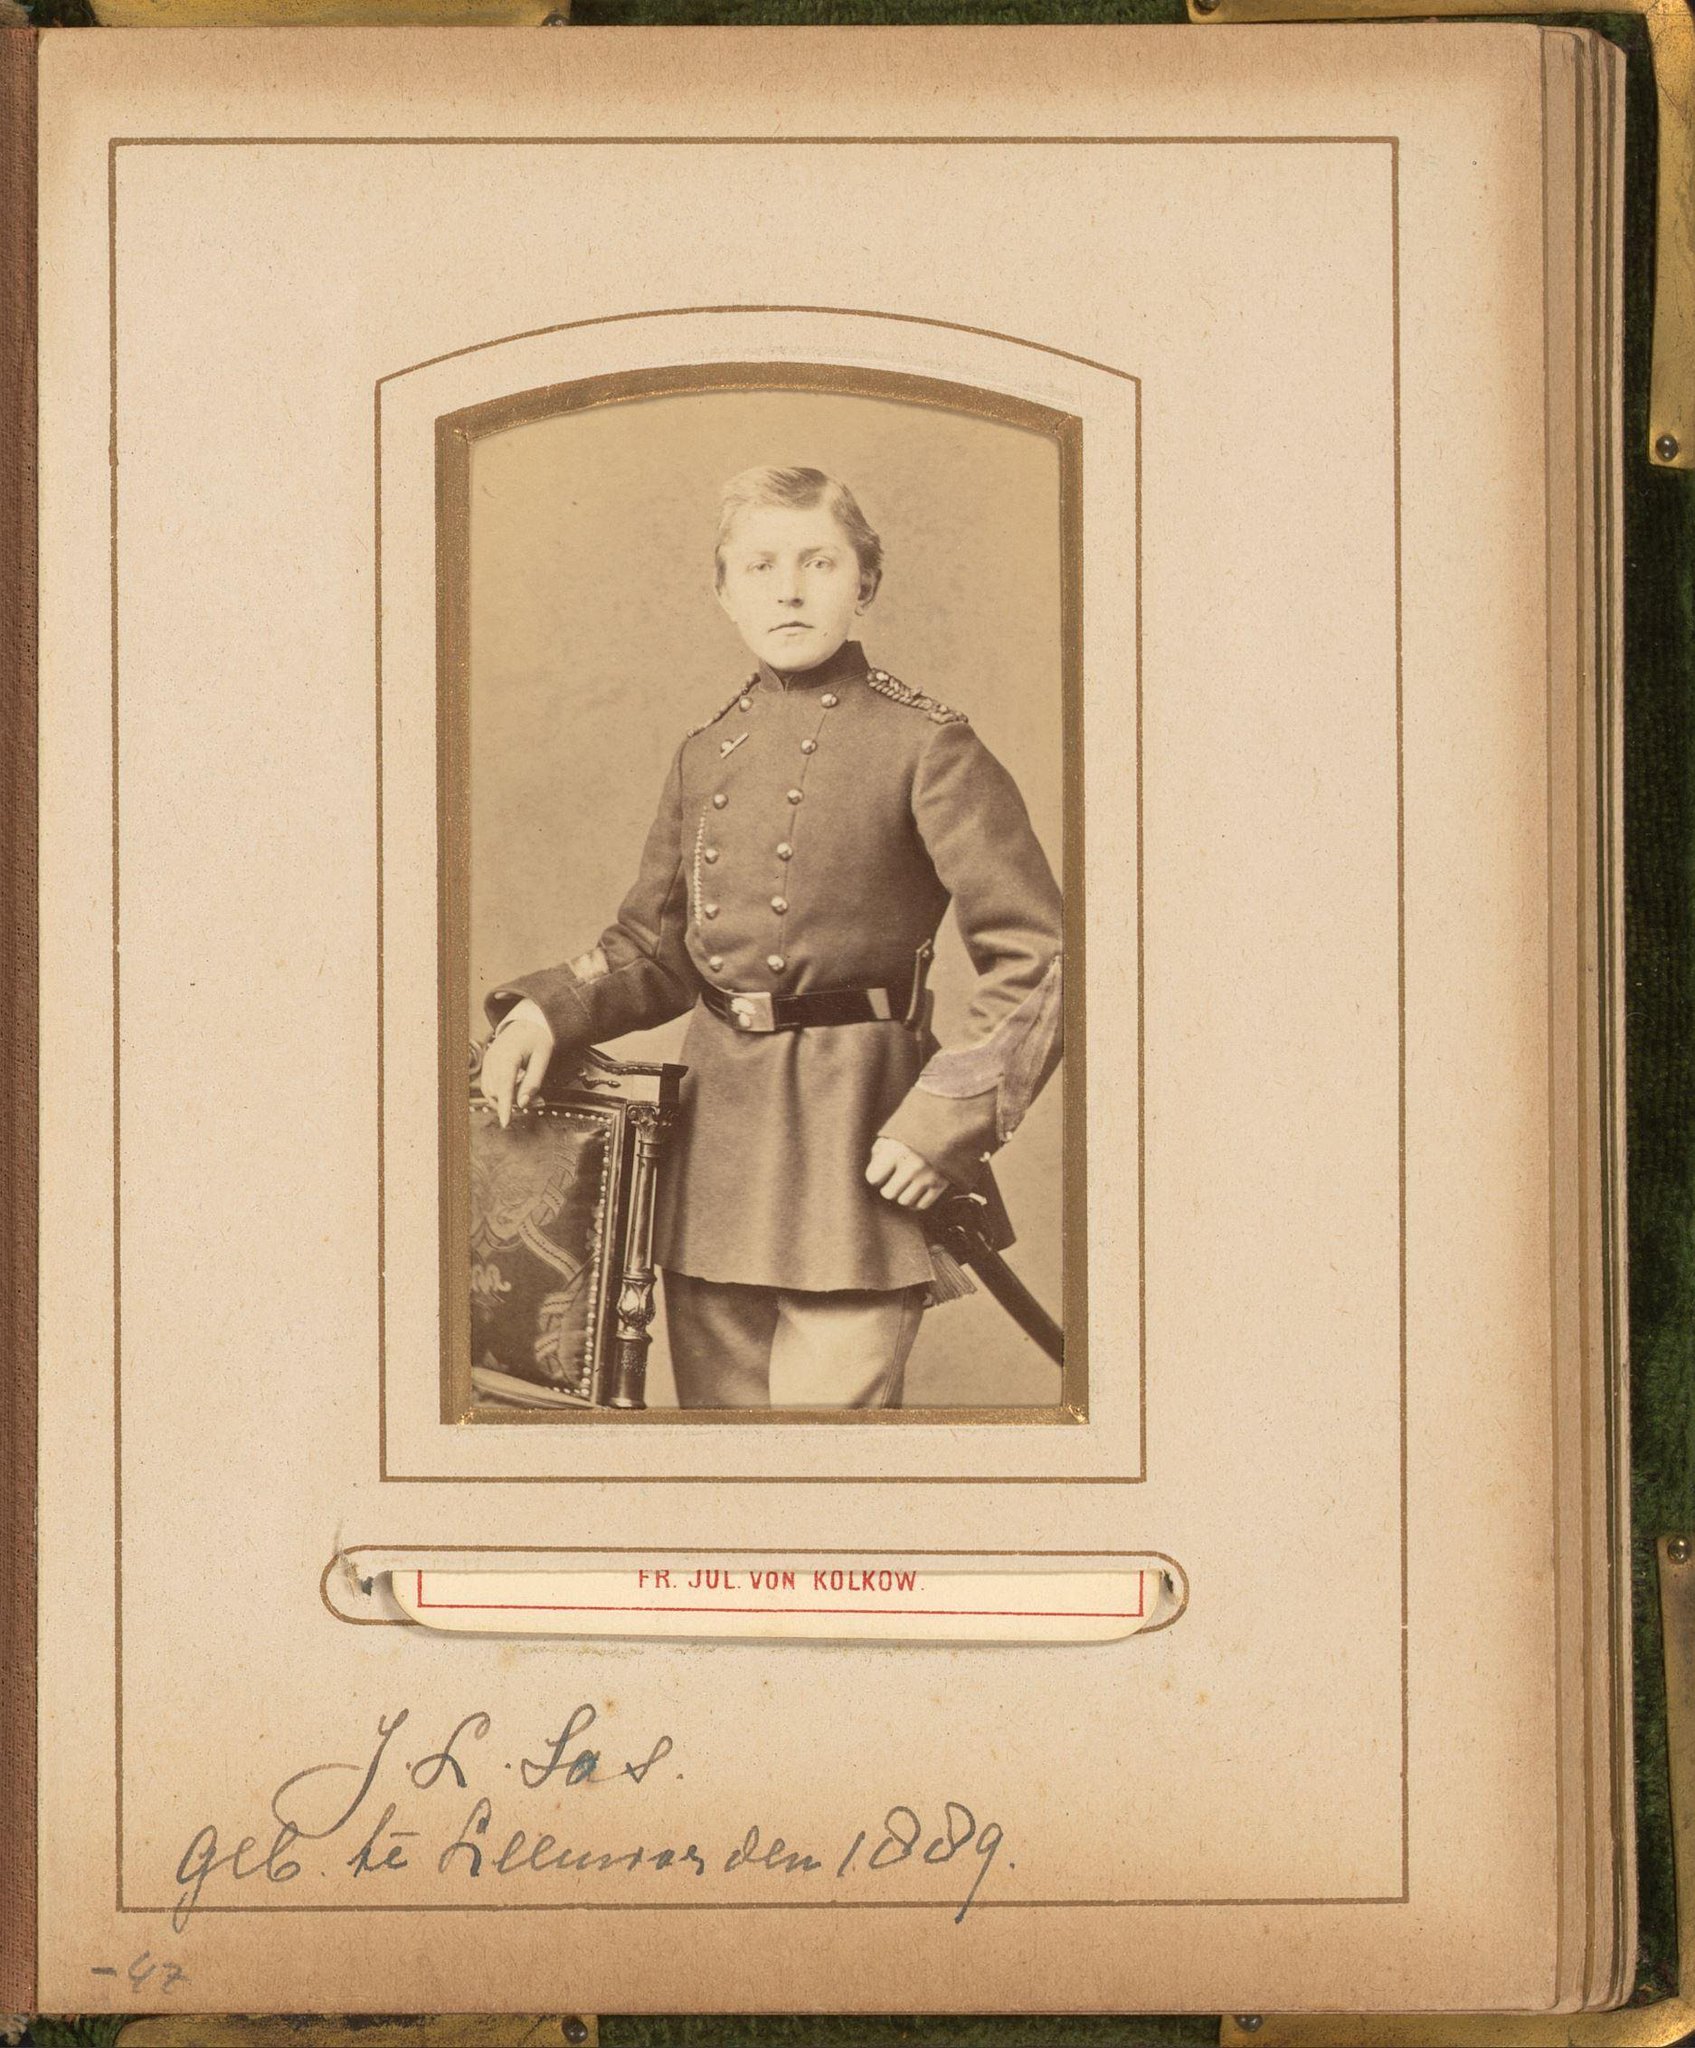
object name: carte de visite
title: Portret van een jongen in militair uniform, aangeduid als J.L. Las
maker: friedrich julius von kolkow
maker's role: fotograaf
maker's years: 1839-1914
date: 1873-1913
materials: cardboard, paper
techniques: albumen print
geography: groningen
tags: youth, adolescent, anonymous historical person portrayed, (military) uniforms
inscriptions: inscription: ‘J.L. Las./ geb. te Leeuwarden 1889.’, inscription: ‘WERELD-TENTOONSTELLING/ WEENEN/ VERDIENST-MEDAILLE./ 1873/ 1866 Amsterdam/ ZILVEREN MEDAILLEN 1869 Groningen/ 1872 Winsum-Hoogezand 1873 Veendam.’